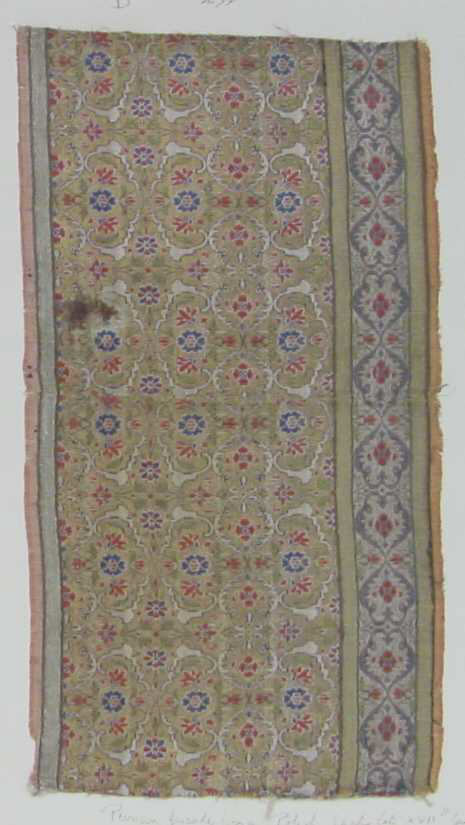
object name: textile fragment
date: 1667-1700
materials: metal thread, silk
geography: iran